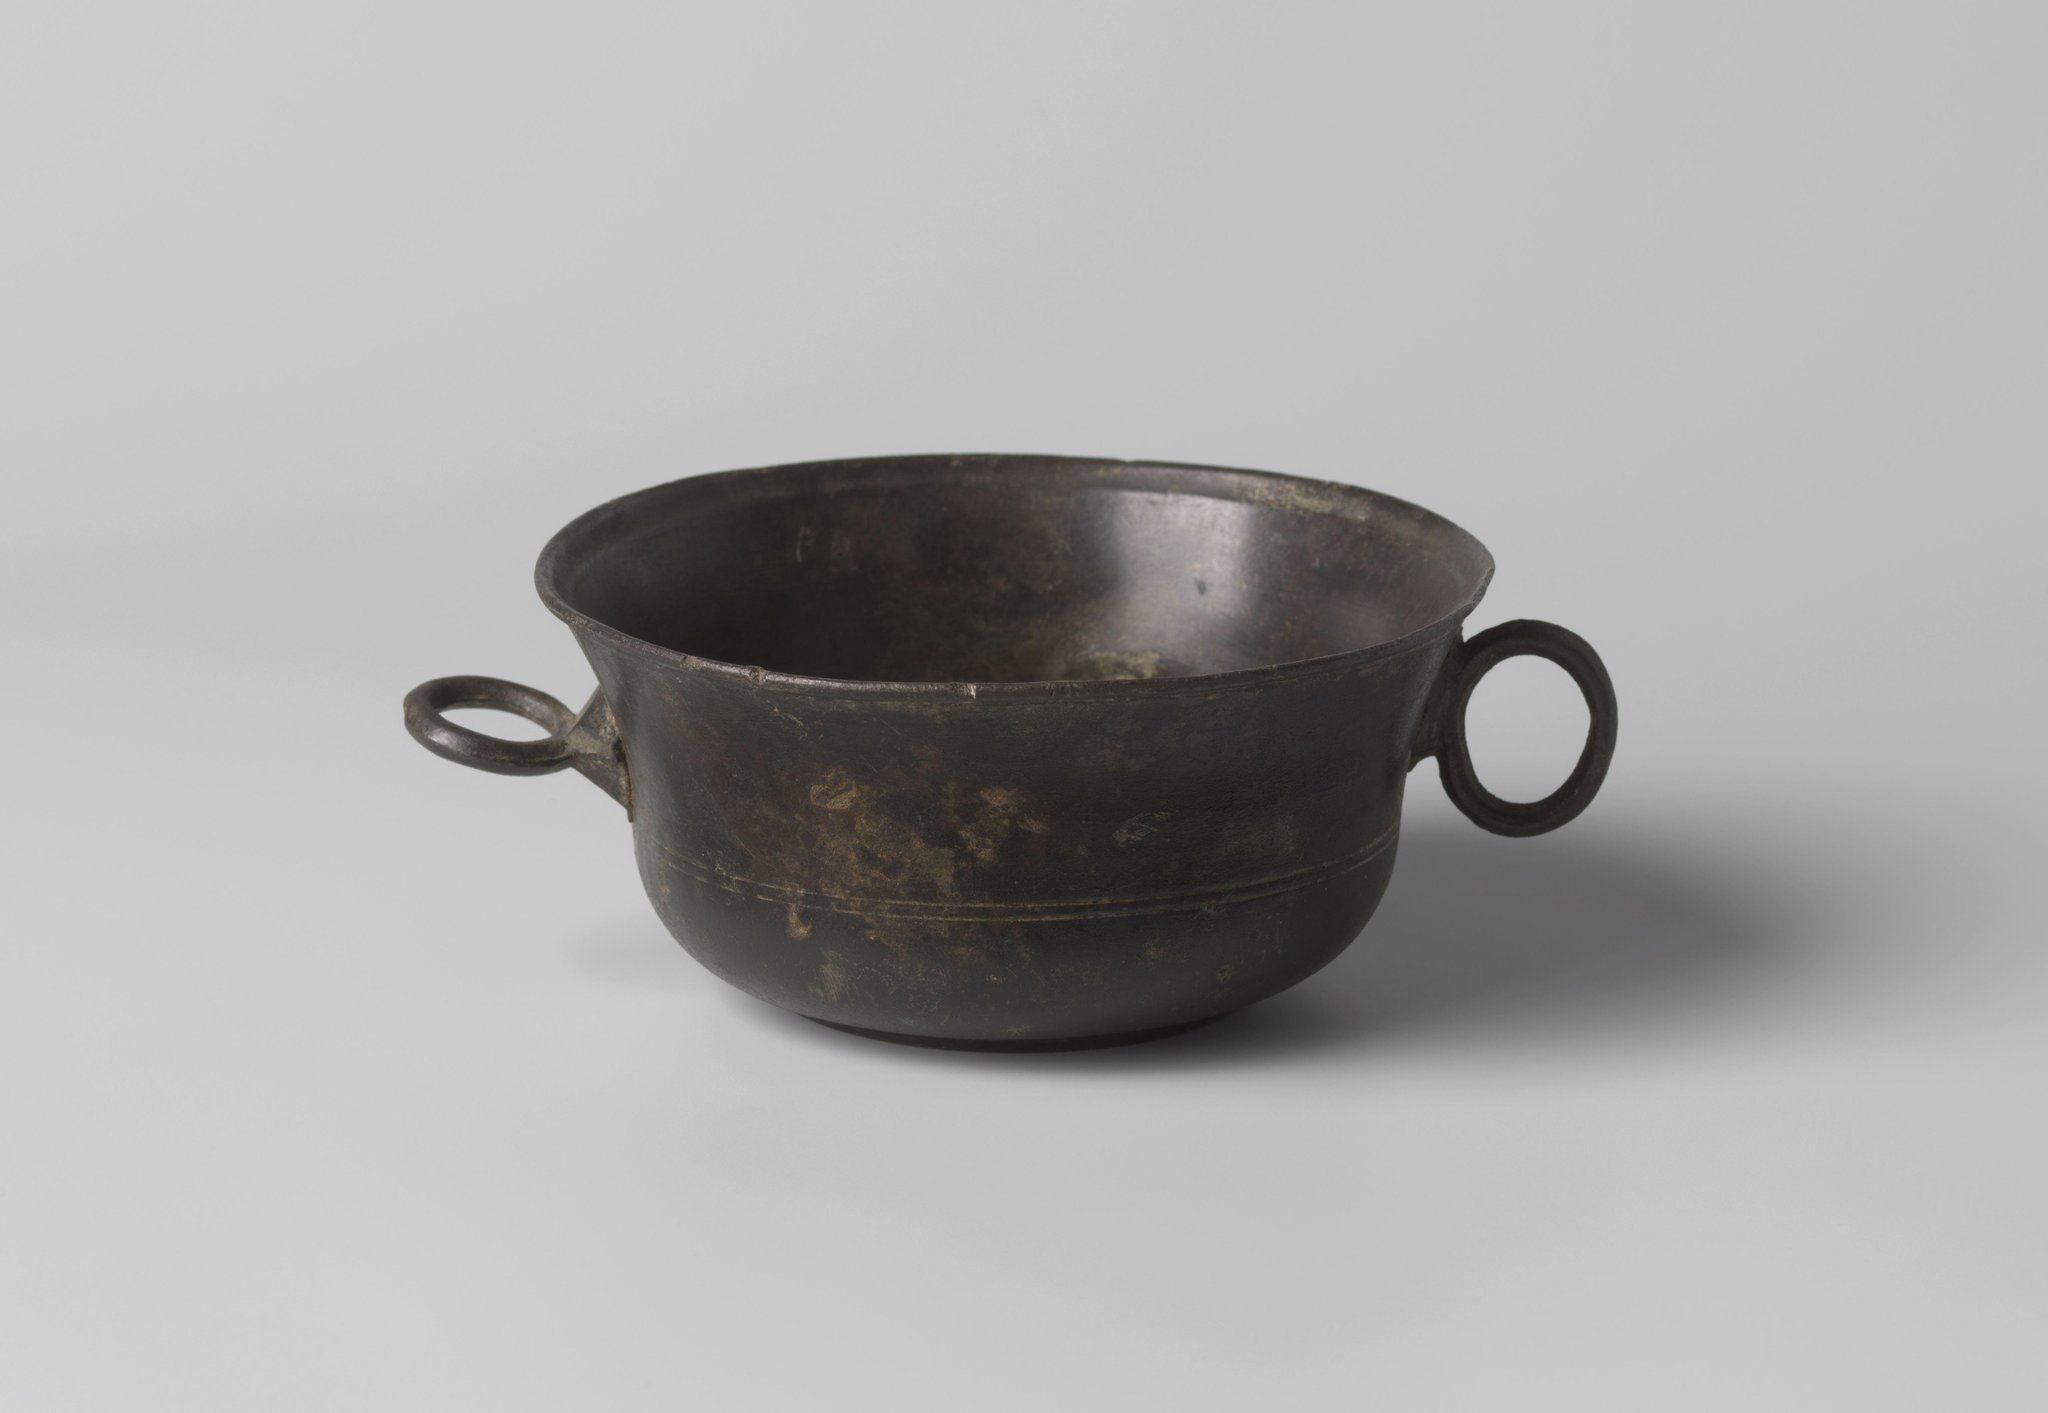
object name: bowl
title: Kom van tin met ringvormige oren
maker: Anonymous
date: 1400-1600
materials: tin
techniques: casting, turning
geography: leiden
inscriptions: quality mark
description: Porringer. Pewter. Marked on the base with the arms of Leiden. Leiden, c. 1500 - 1550.